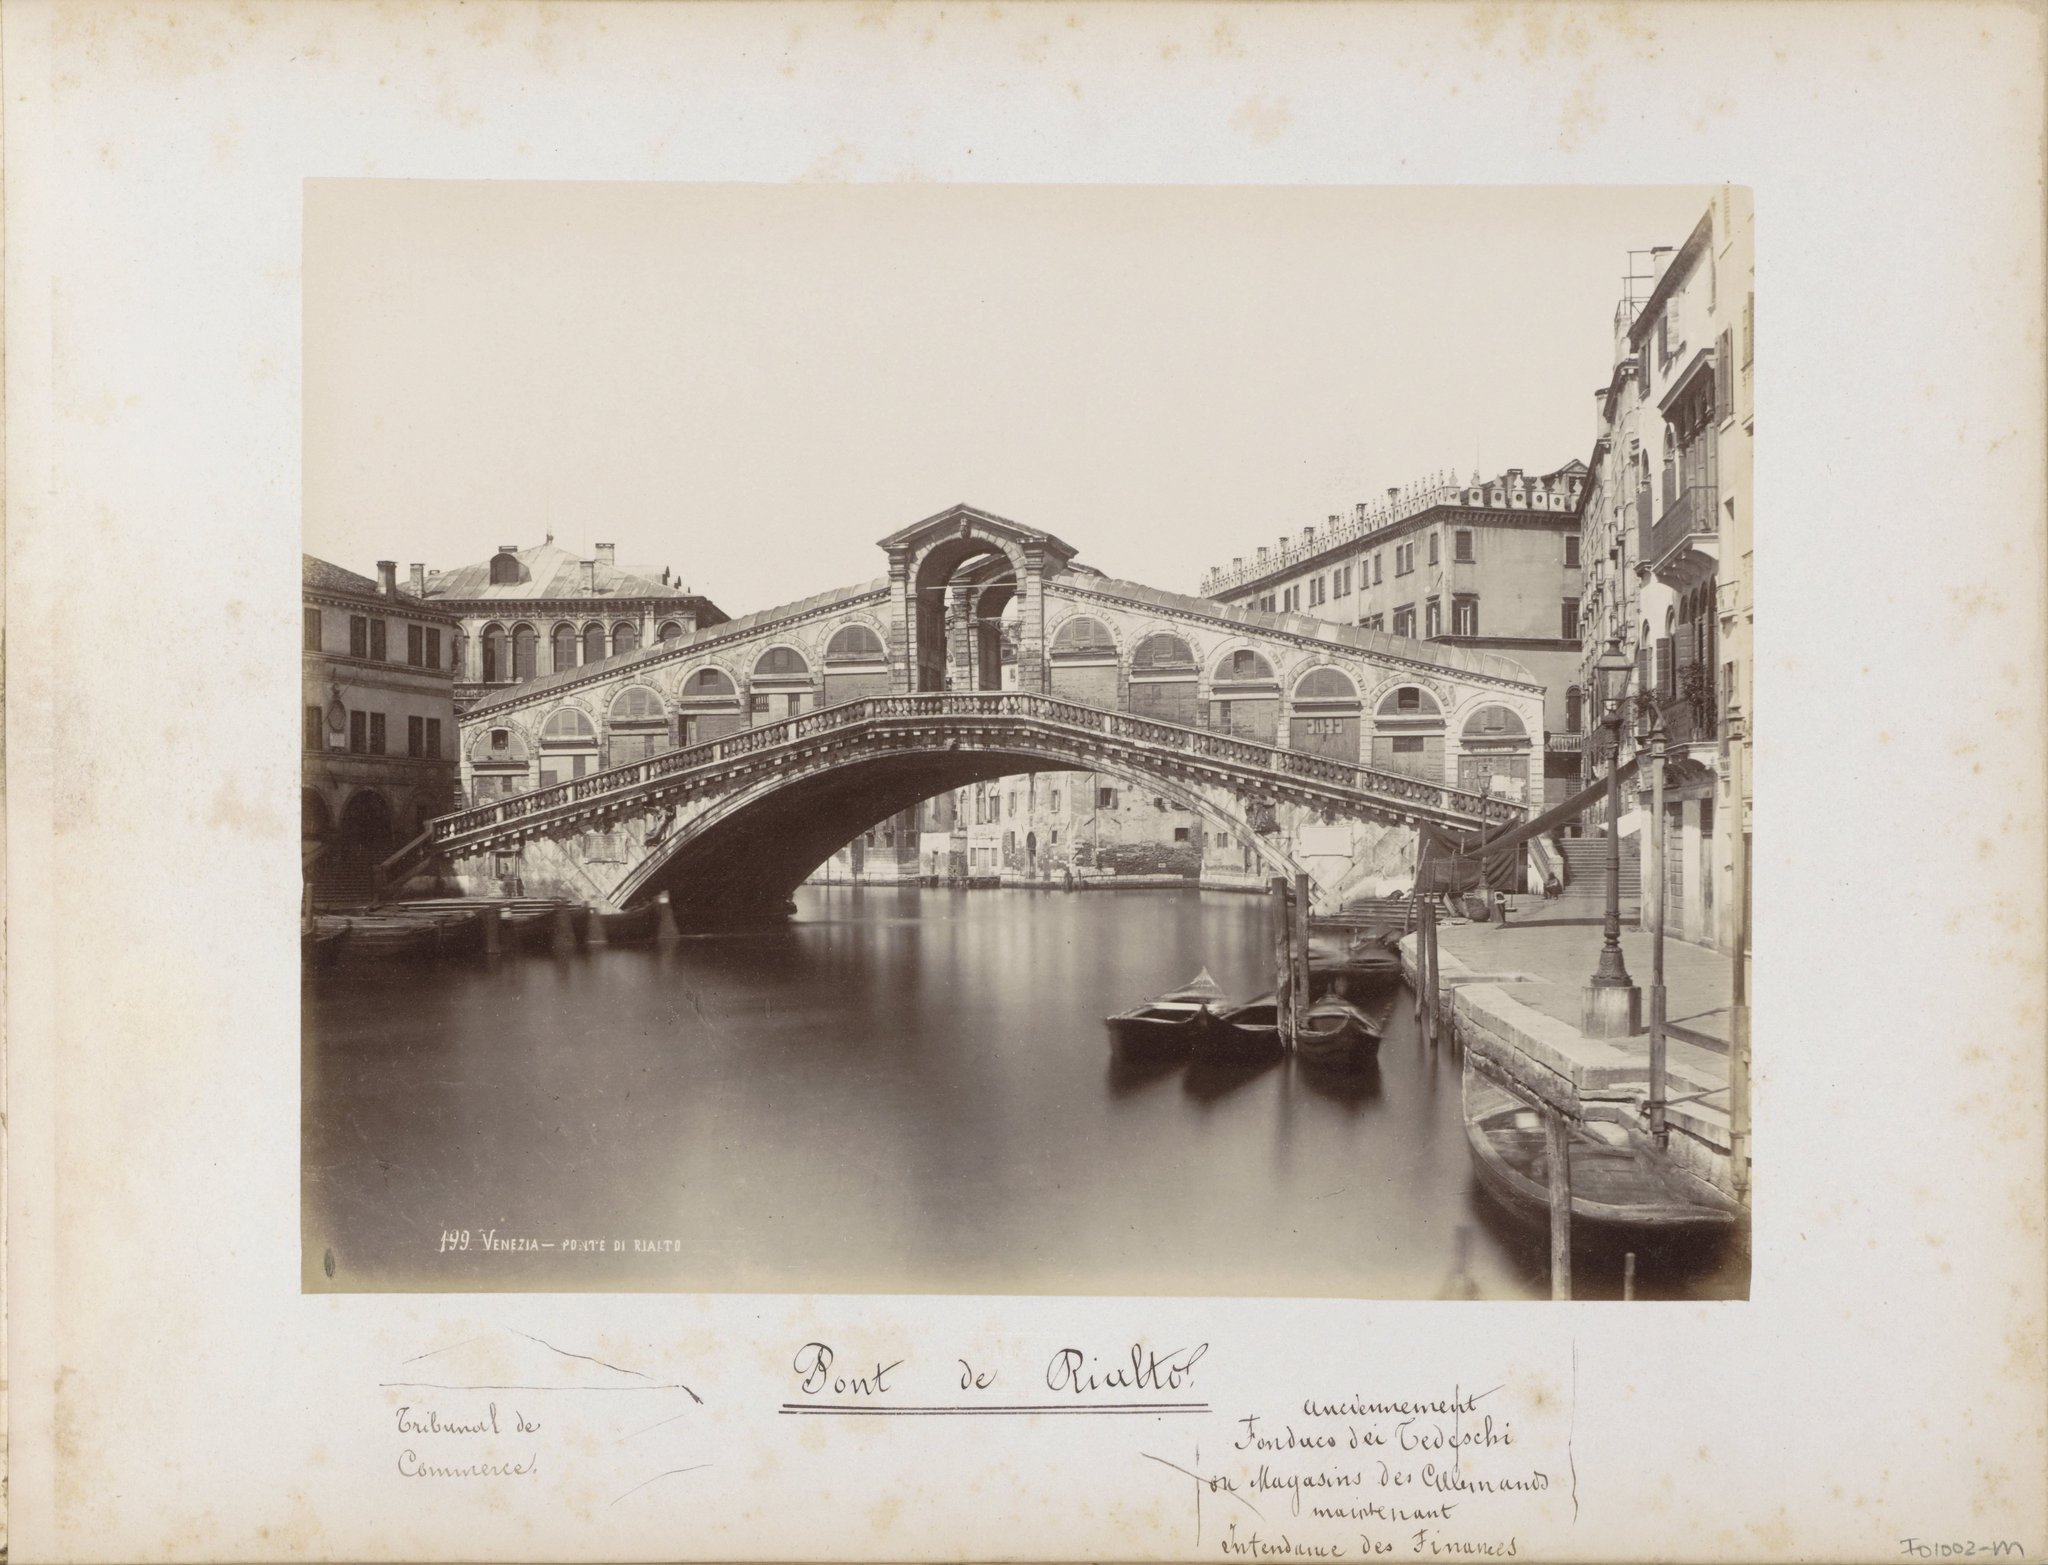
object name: photograph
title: Pont de Rialto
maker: carlo ponti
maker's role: fotograaf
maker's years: 1820-1893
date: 1860-1881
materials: photographic support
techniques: albumen print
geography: venice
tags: canal, bridge, gondola, venice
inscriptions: check stamp: ‘Carlo Ponti Venezia’, negative number: ‘199’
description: Onderdeel van Topografisch album van Venetië 1881.